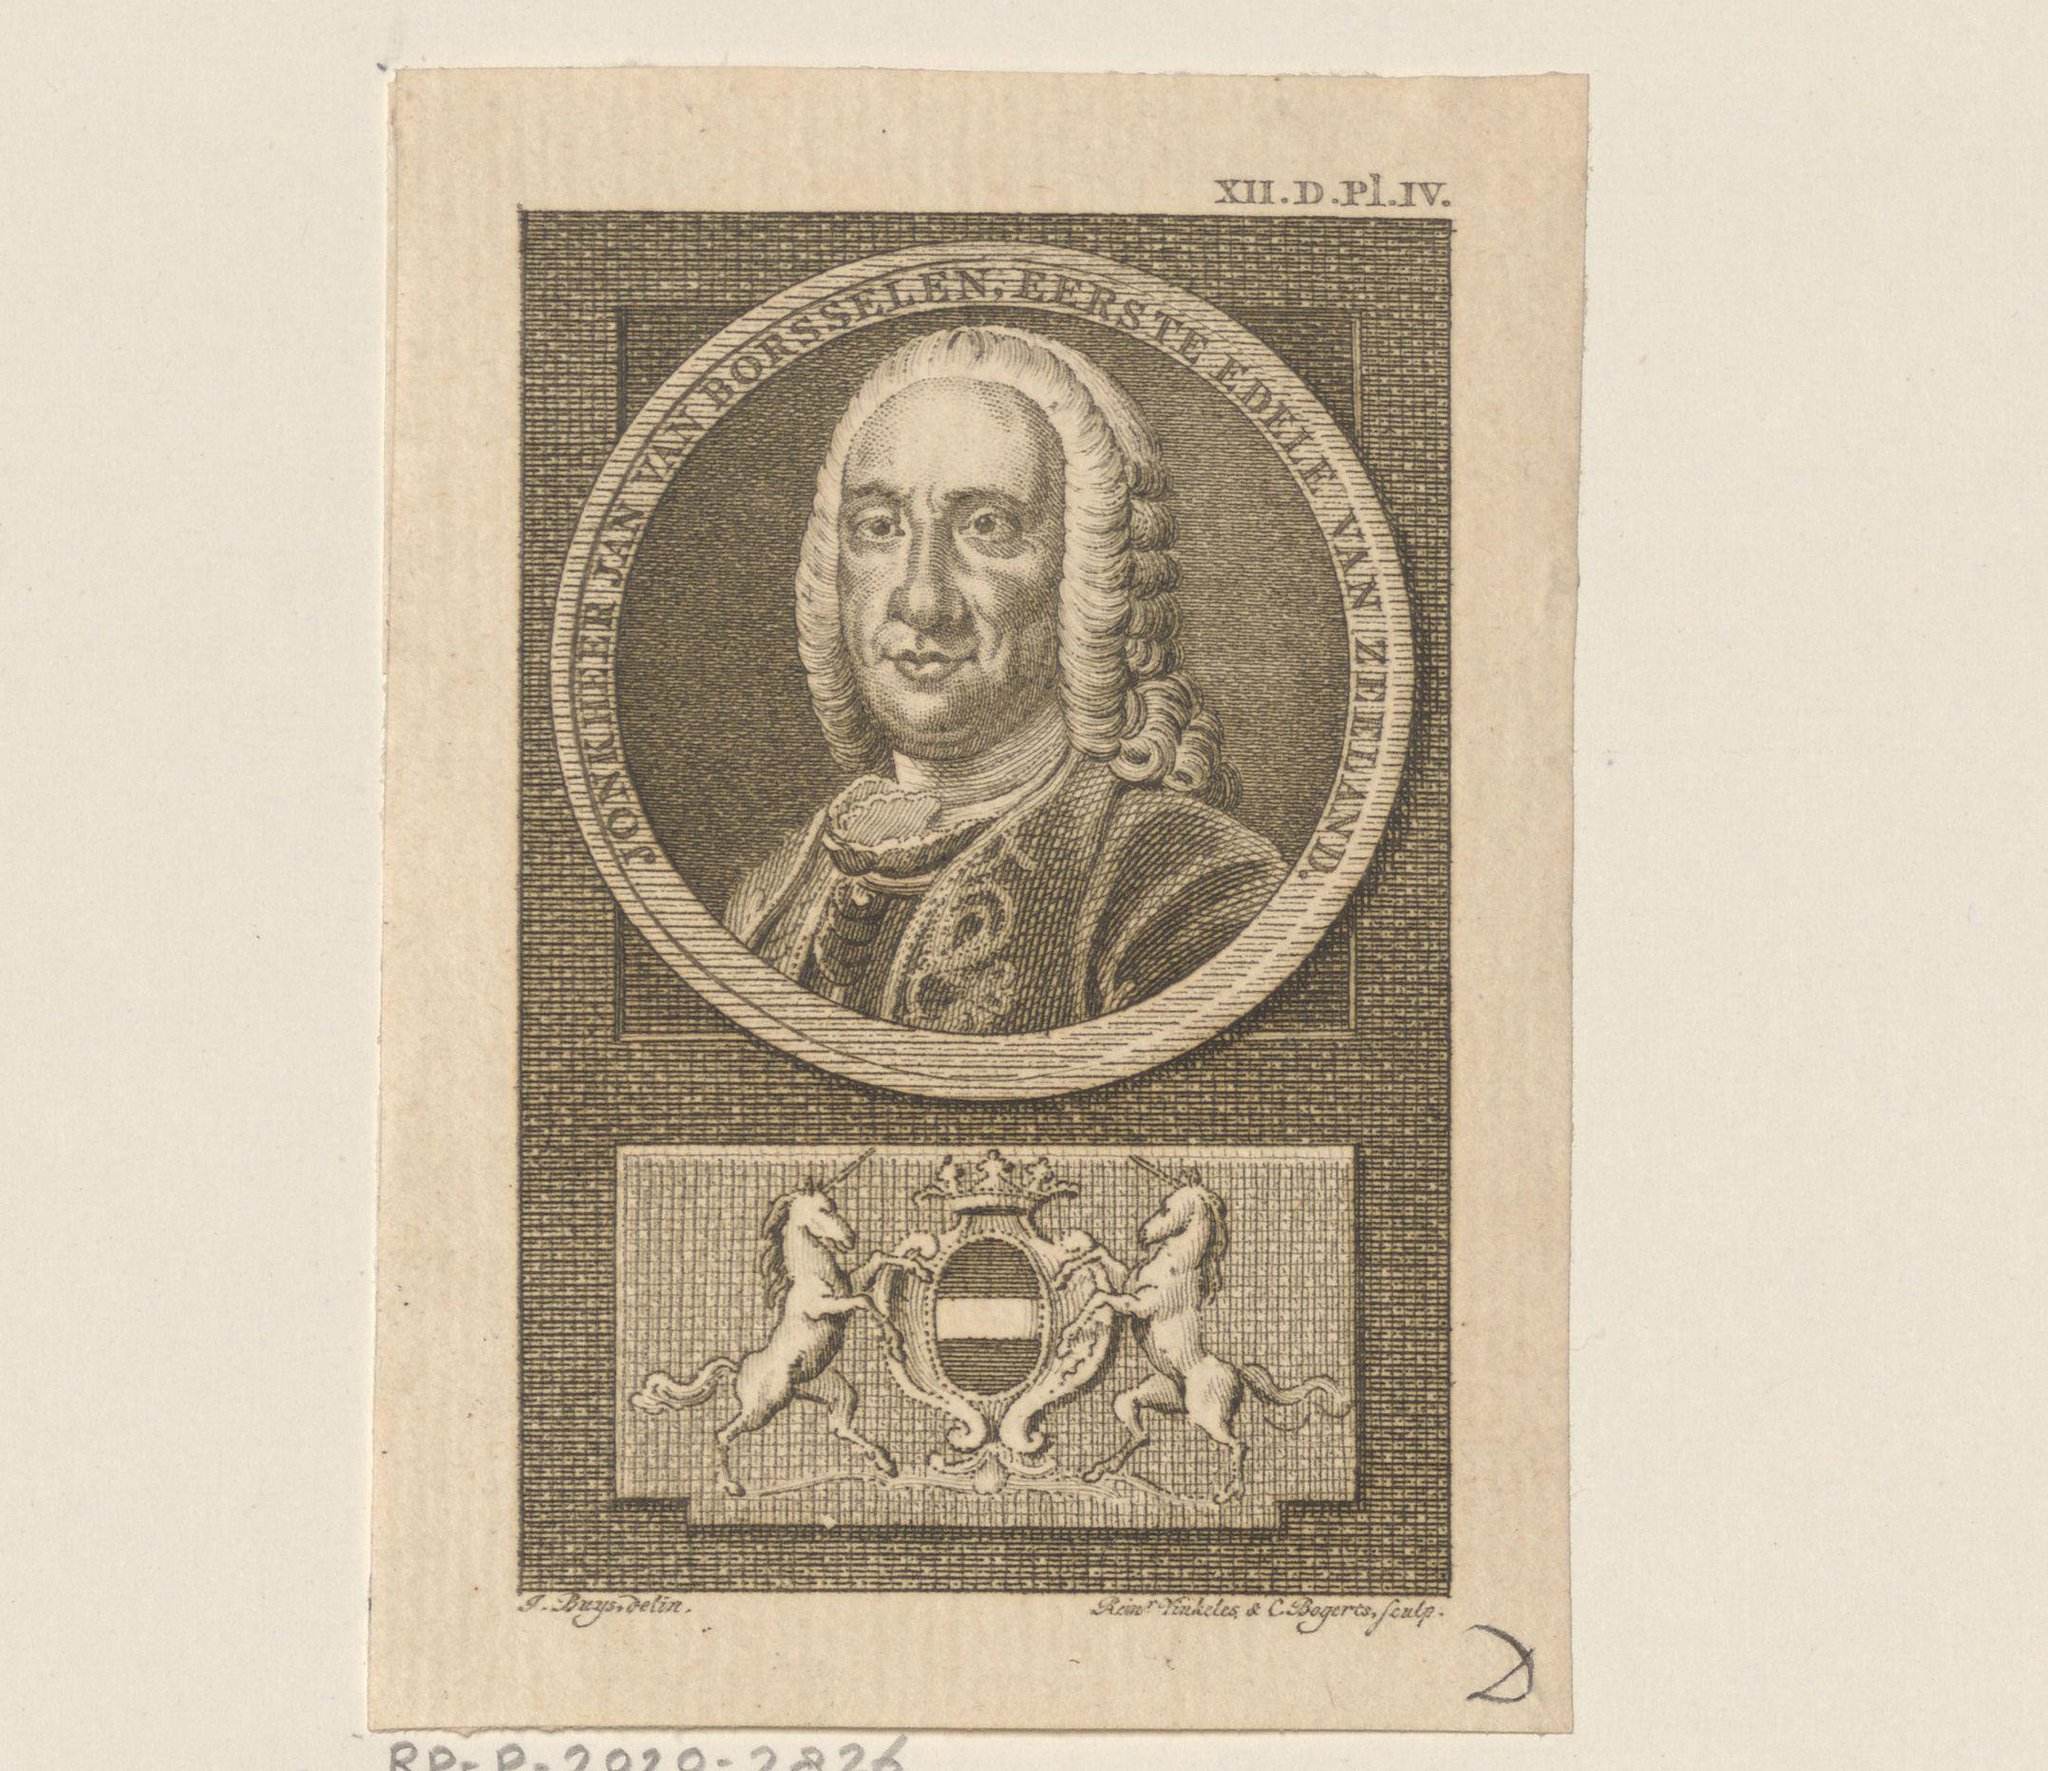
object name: book illustration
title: Portret van Jan van Borssele van der Hooghe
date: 1783-1795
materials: paper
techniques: engraving, etching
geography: amsterdam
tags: the hague, historical persons, armorial bearing, heraldry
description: Prent uit: Fokke, Jan. Geschiedenissen der Vereenigde Nederlanden voor de vaderlandsche jeugd (...). Amsterdam: Johannes Allart, 1783-1795, dl. 12.